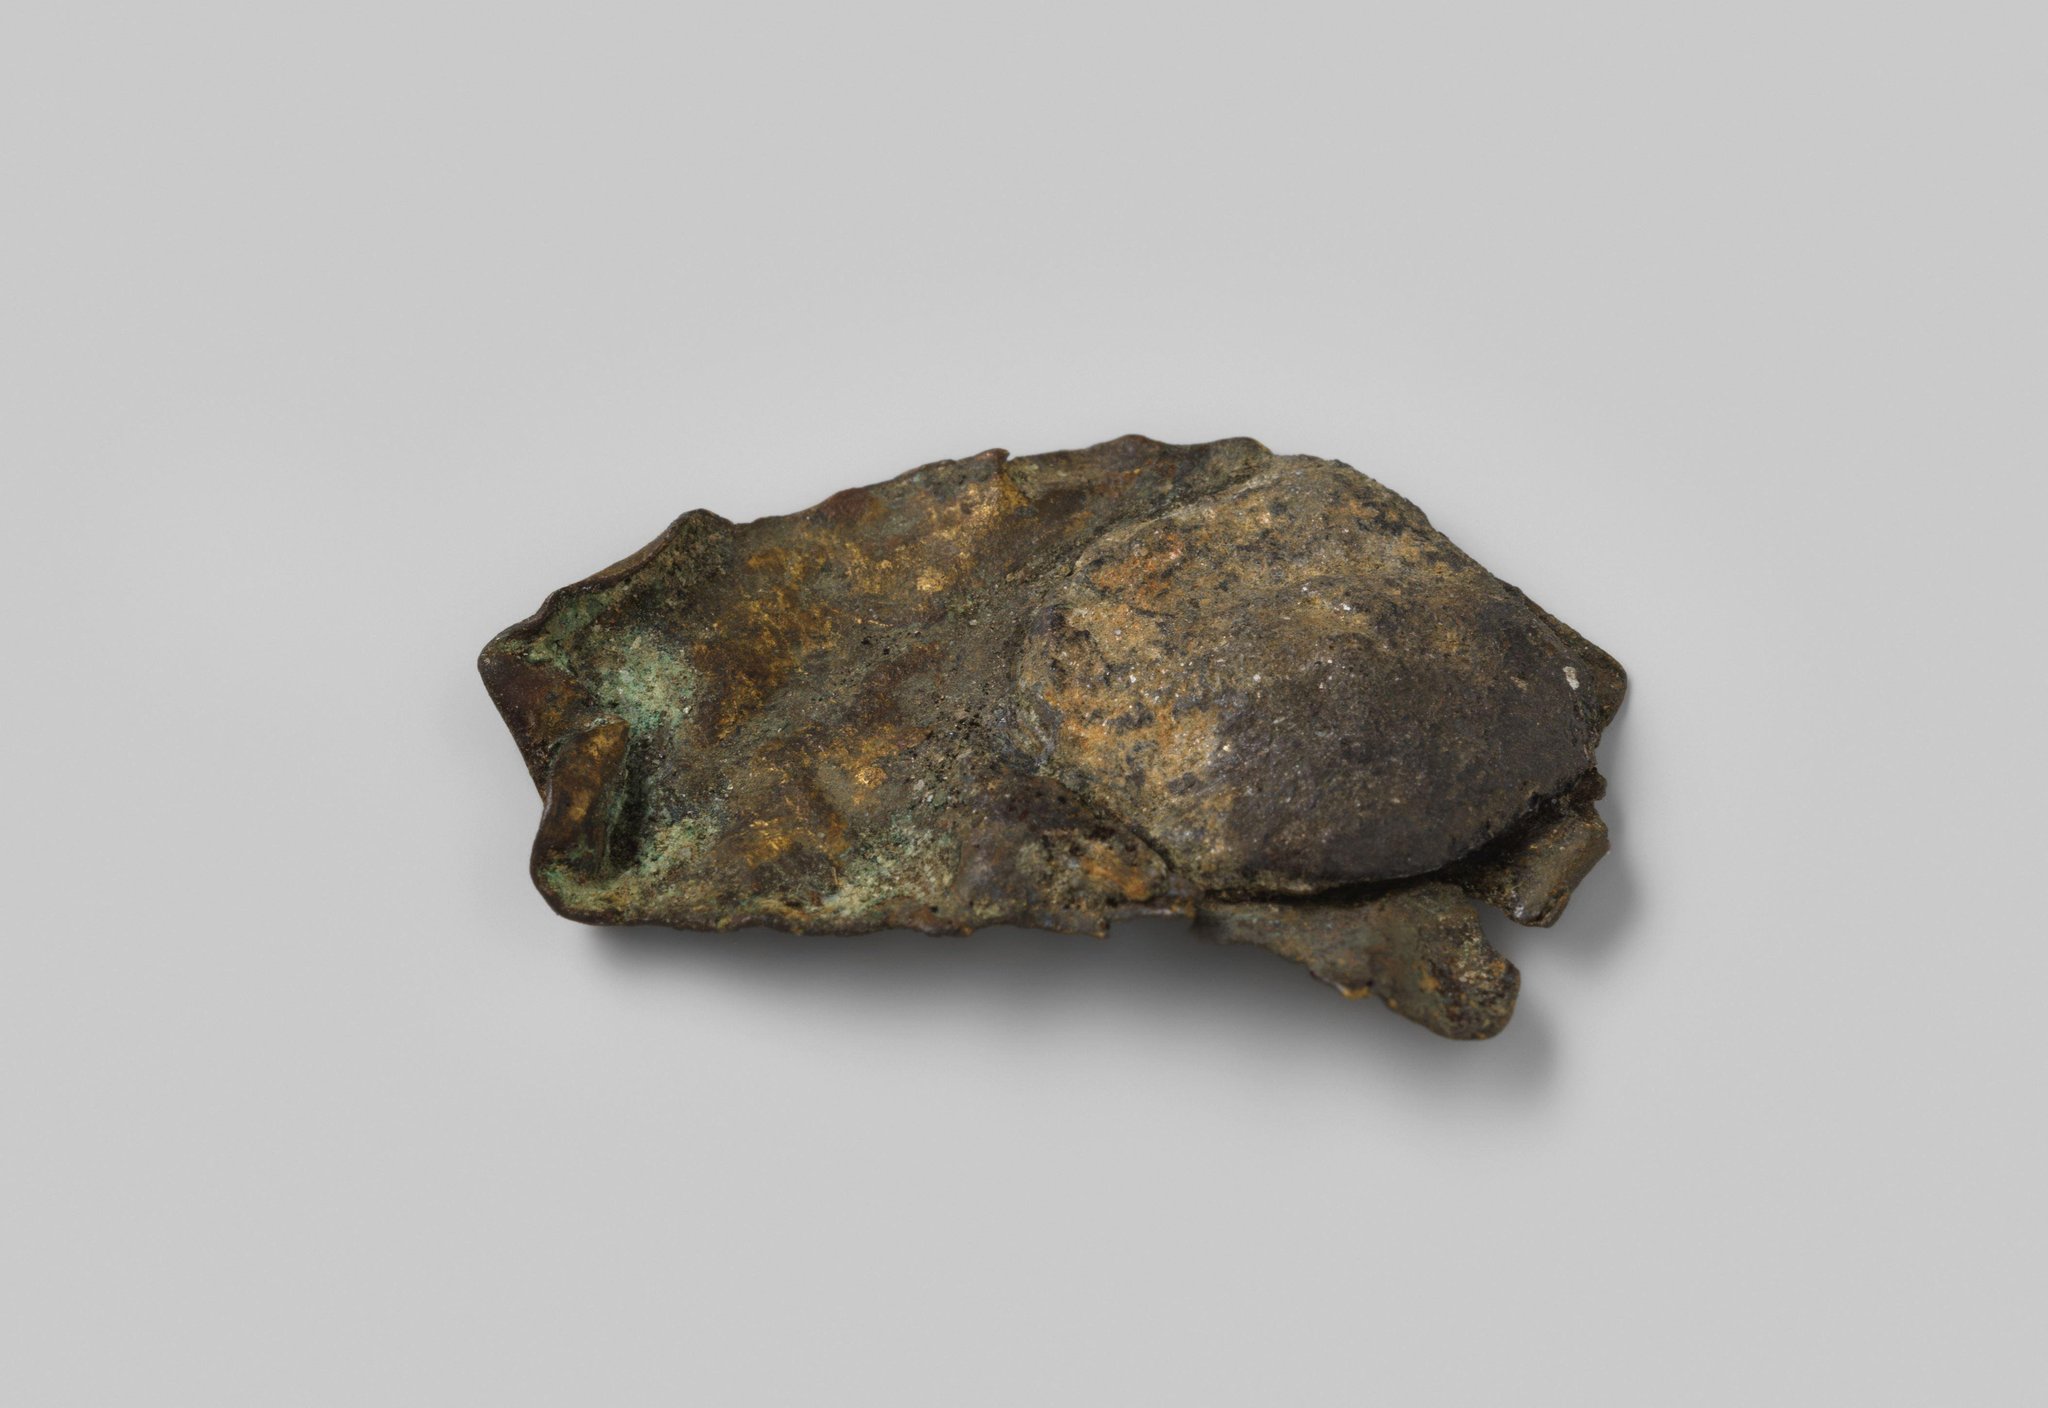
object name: fragment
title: Fragment uit het wrak van de Oost-Indiëvaarder Hollandia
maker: Anonymous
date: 1700-1743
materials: copper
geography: netherlands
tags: verenigde oostindische compagnie, hollandia (schip), annet